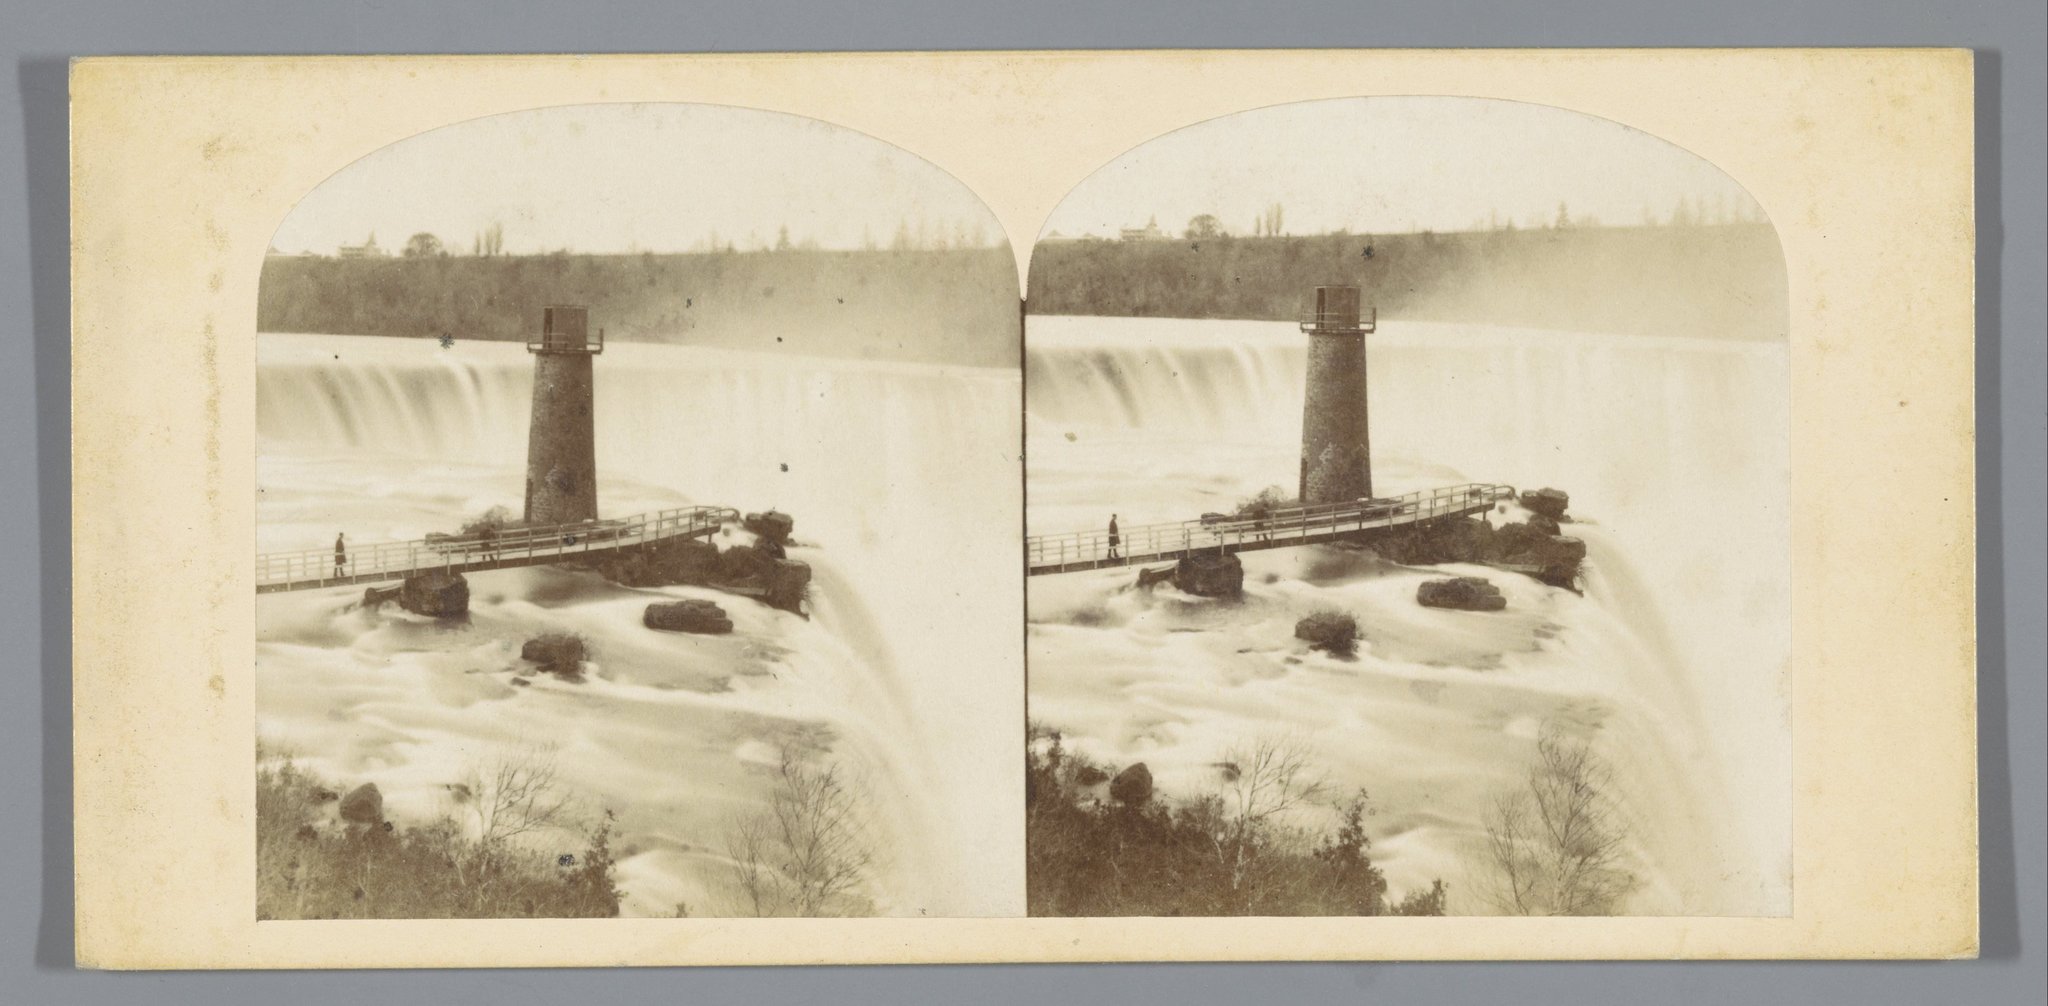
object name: stereograph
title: Horseshoe Falls en Terrapin Tower, gezien vanaf Goat Island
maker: william england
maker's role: fotograaf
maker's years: 1816-1896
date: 1859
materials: cardboard, paper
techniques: albumen print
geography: london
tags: waterfall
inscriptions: : ‘"The Horse Shoe (...) Earl of Carlisle.’